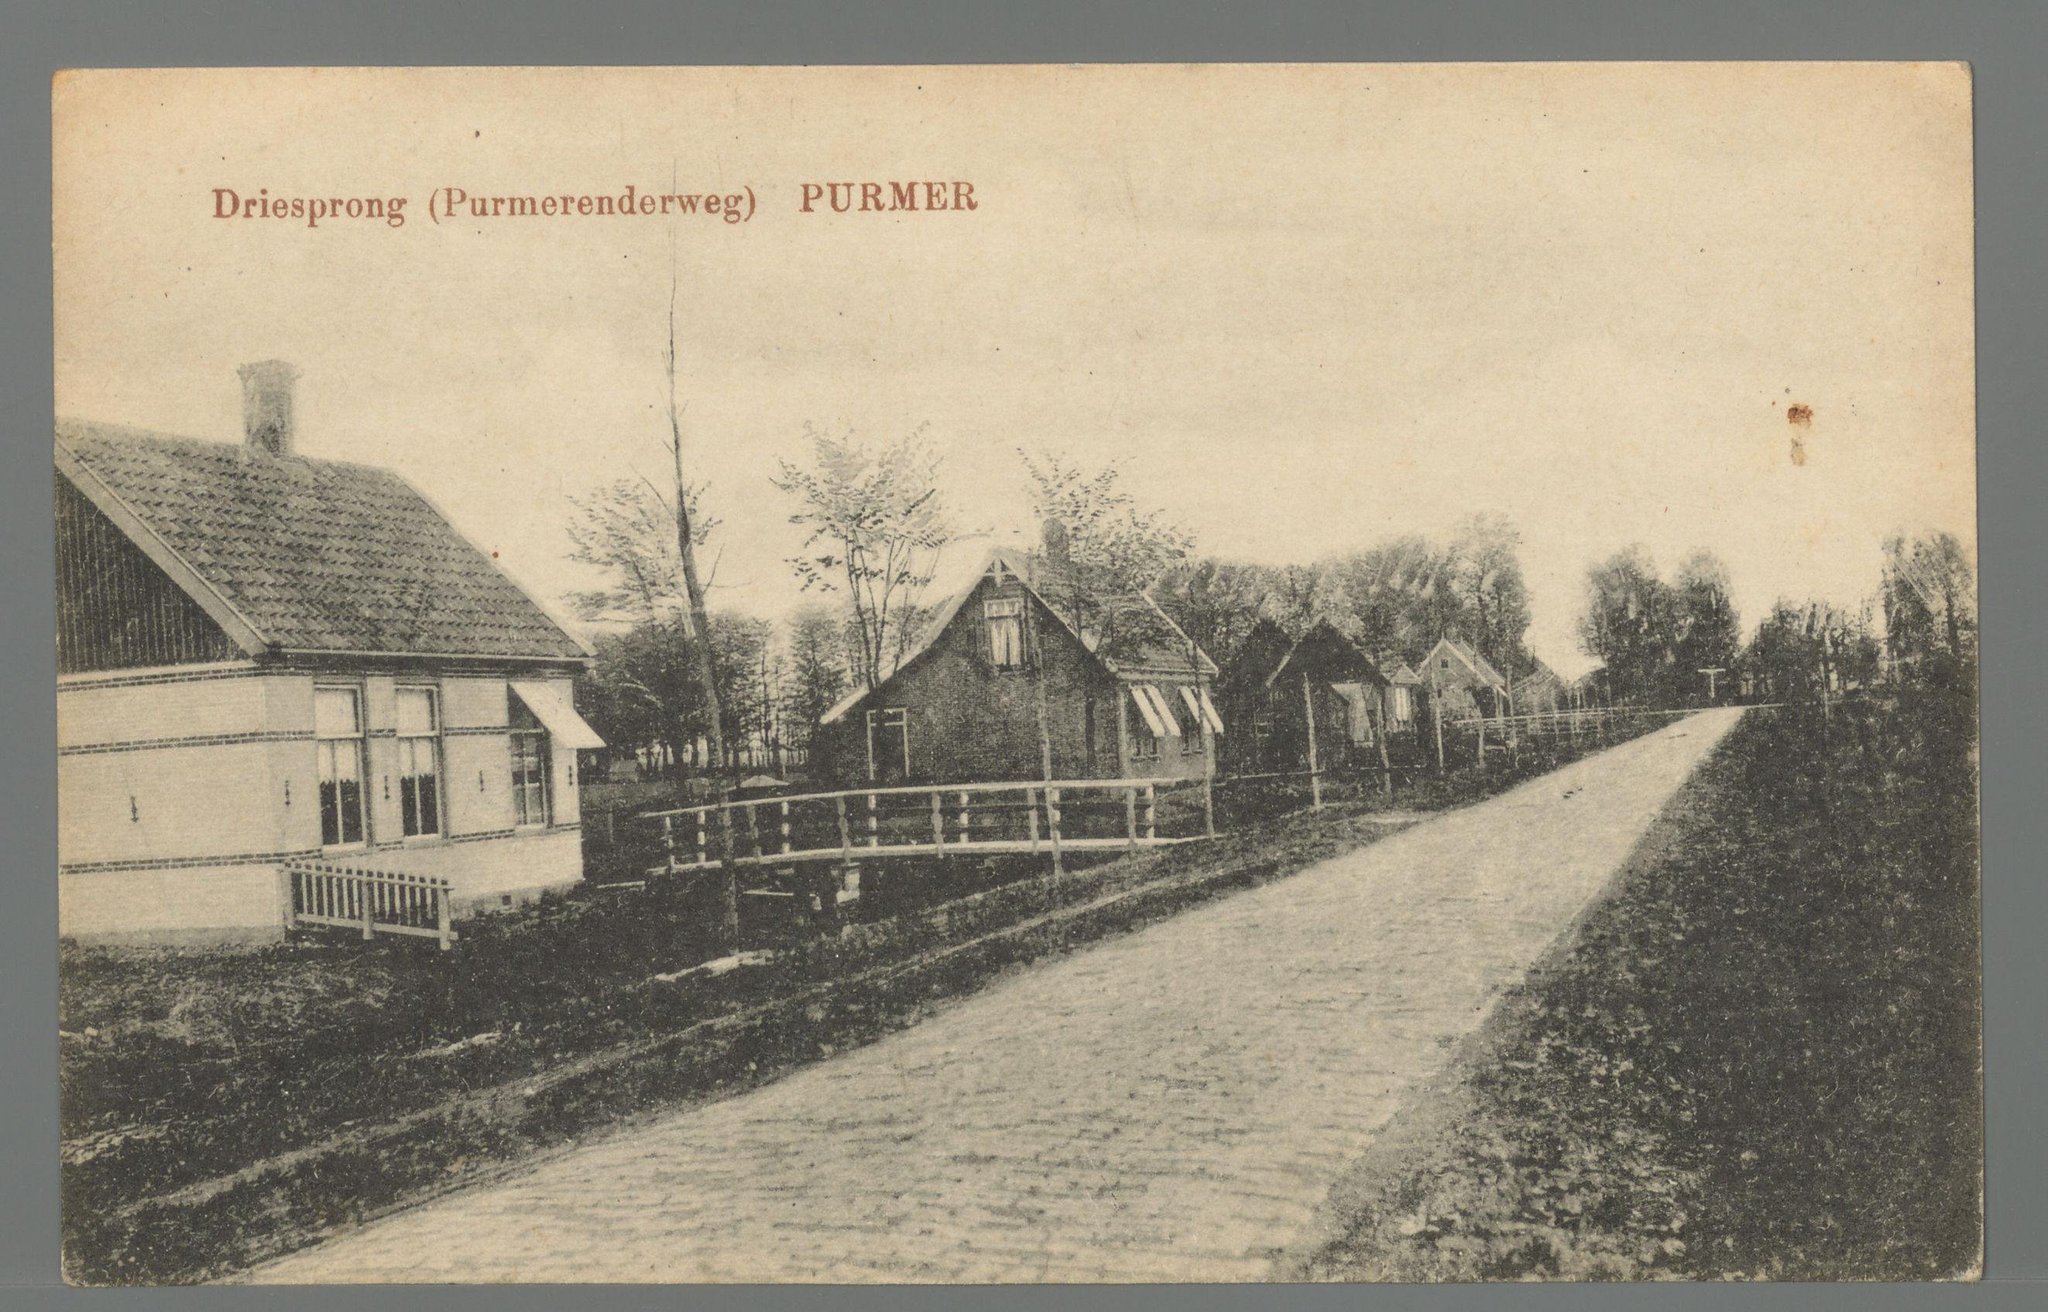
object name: ansichtkaart, prentbriefkaart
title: Driesprong (Purmerenderweg) PURMER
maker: Anonymous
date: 1906-1929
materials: cardboard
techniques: photograph, writing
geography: haarlem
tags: city-view, and landscape with man-made constructions, small canal, ditch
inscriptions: postage stamp